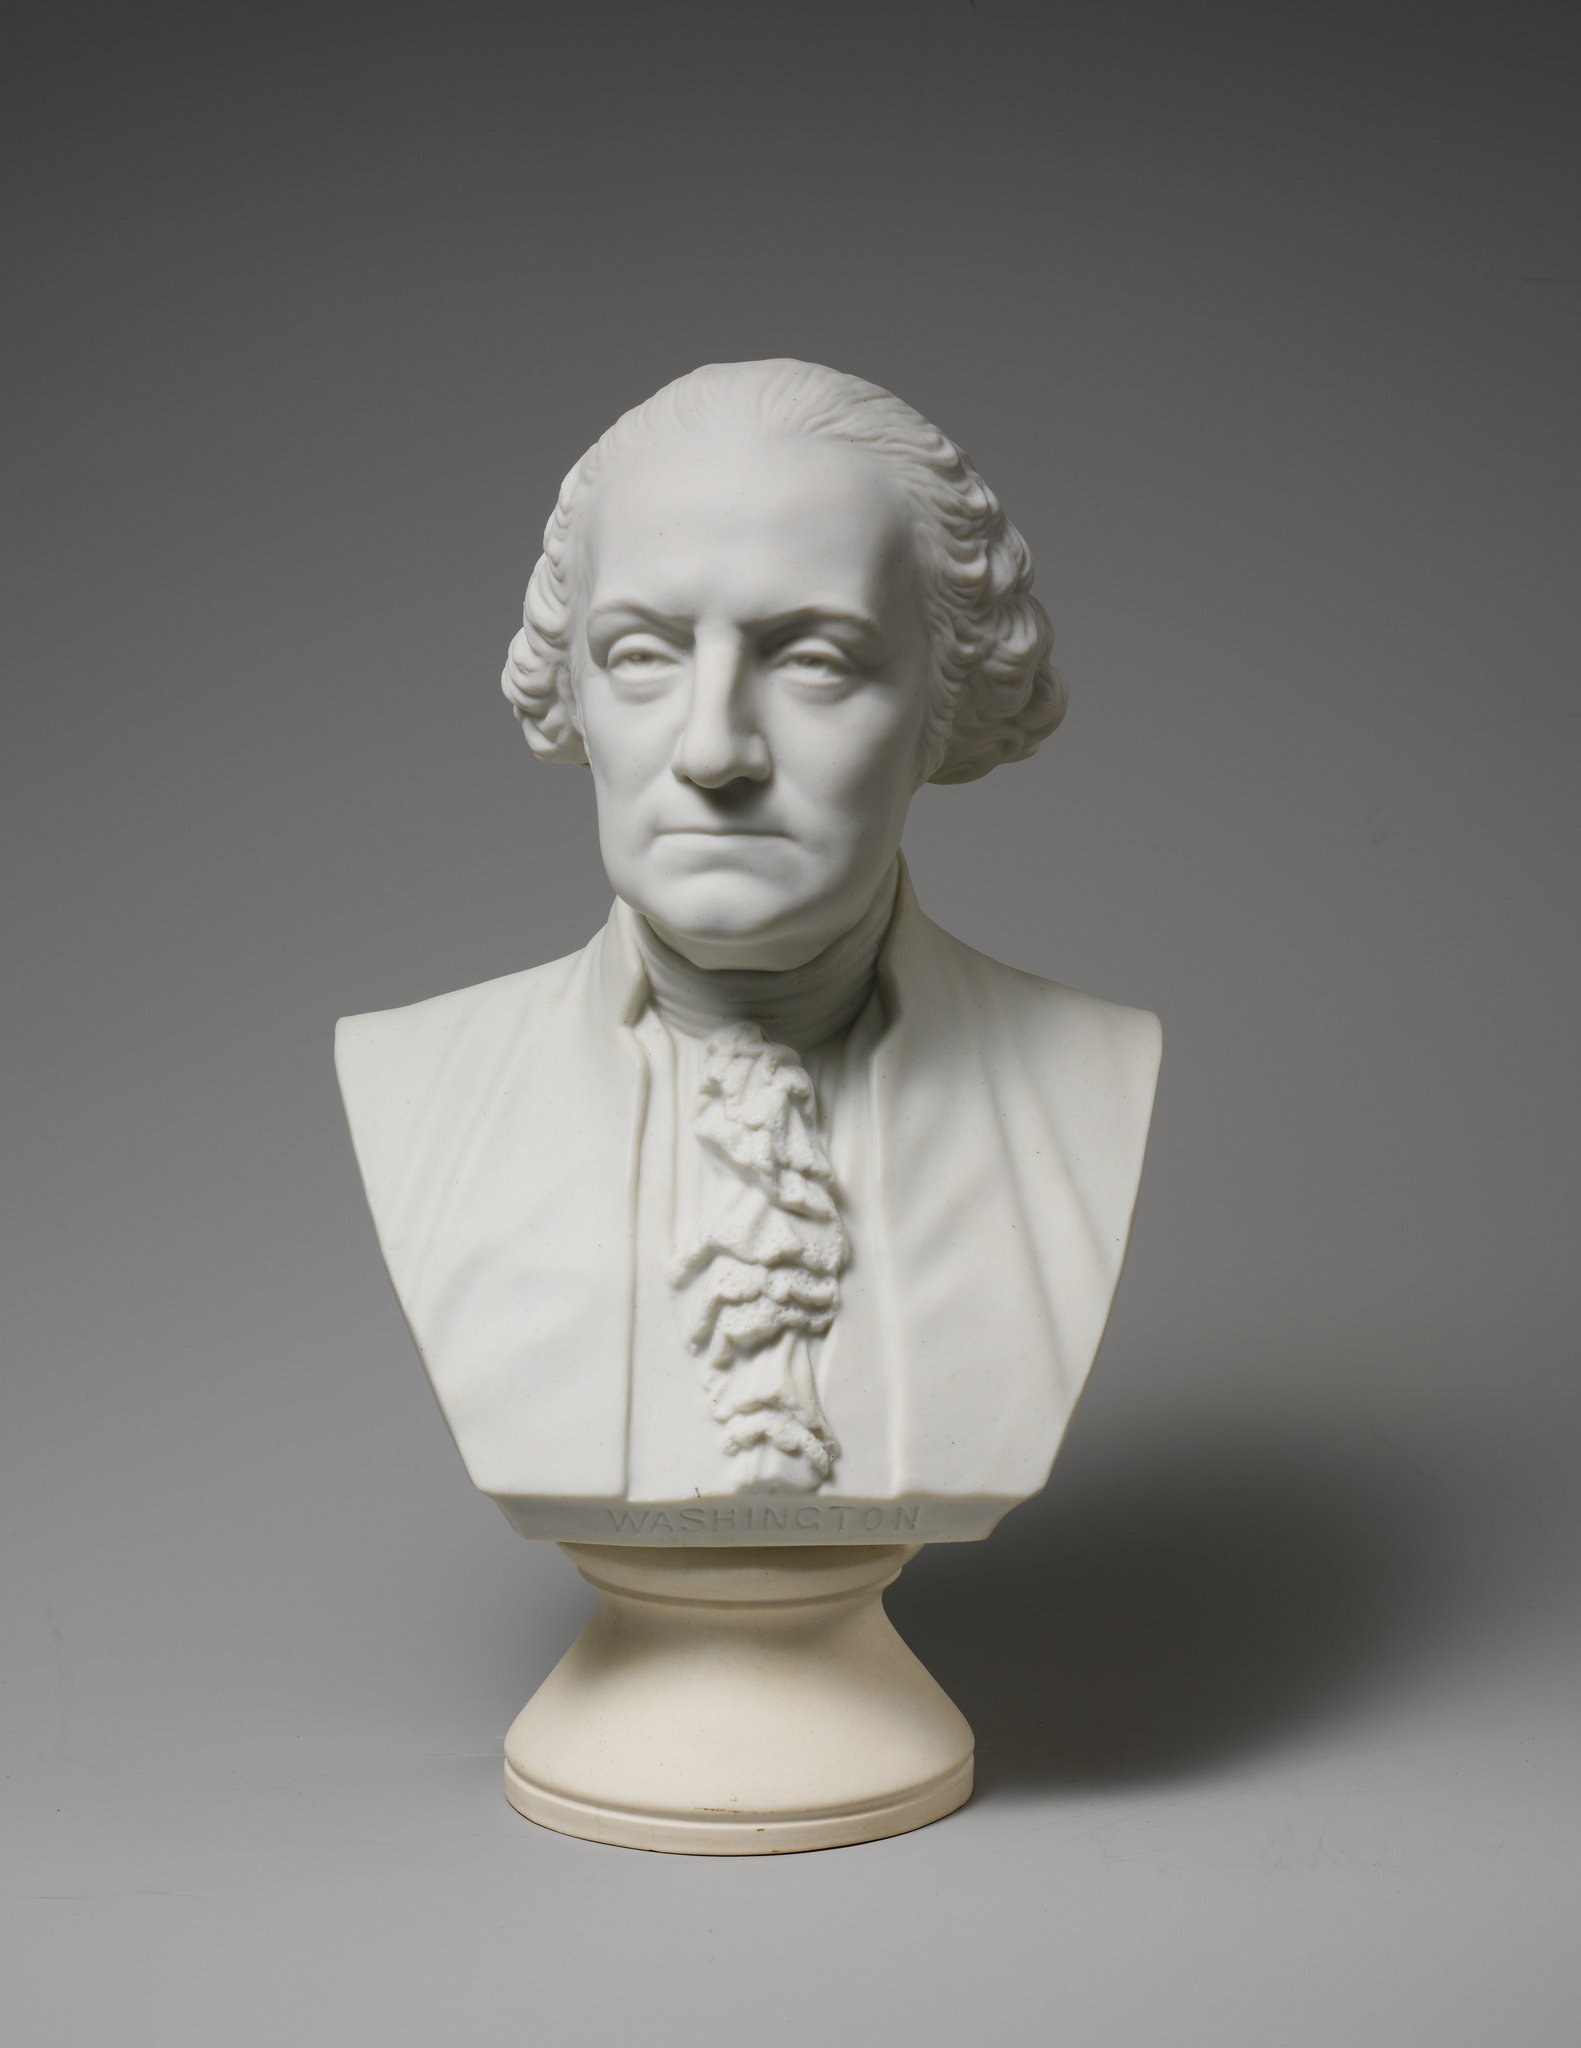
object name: bust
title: George Washington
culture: american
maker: isaac broome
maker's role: artist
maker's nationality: american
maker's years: 1835-1922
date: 1876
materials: porcelain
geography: united states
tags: george washington,men,portraits